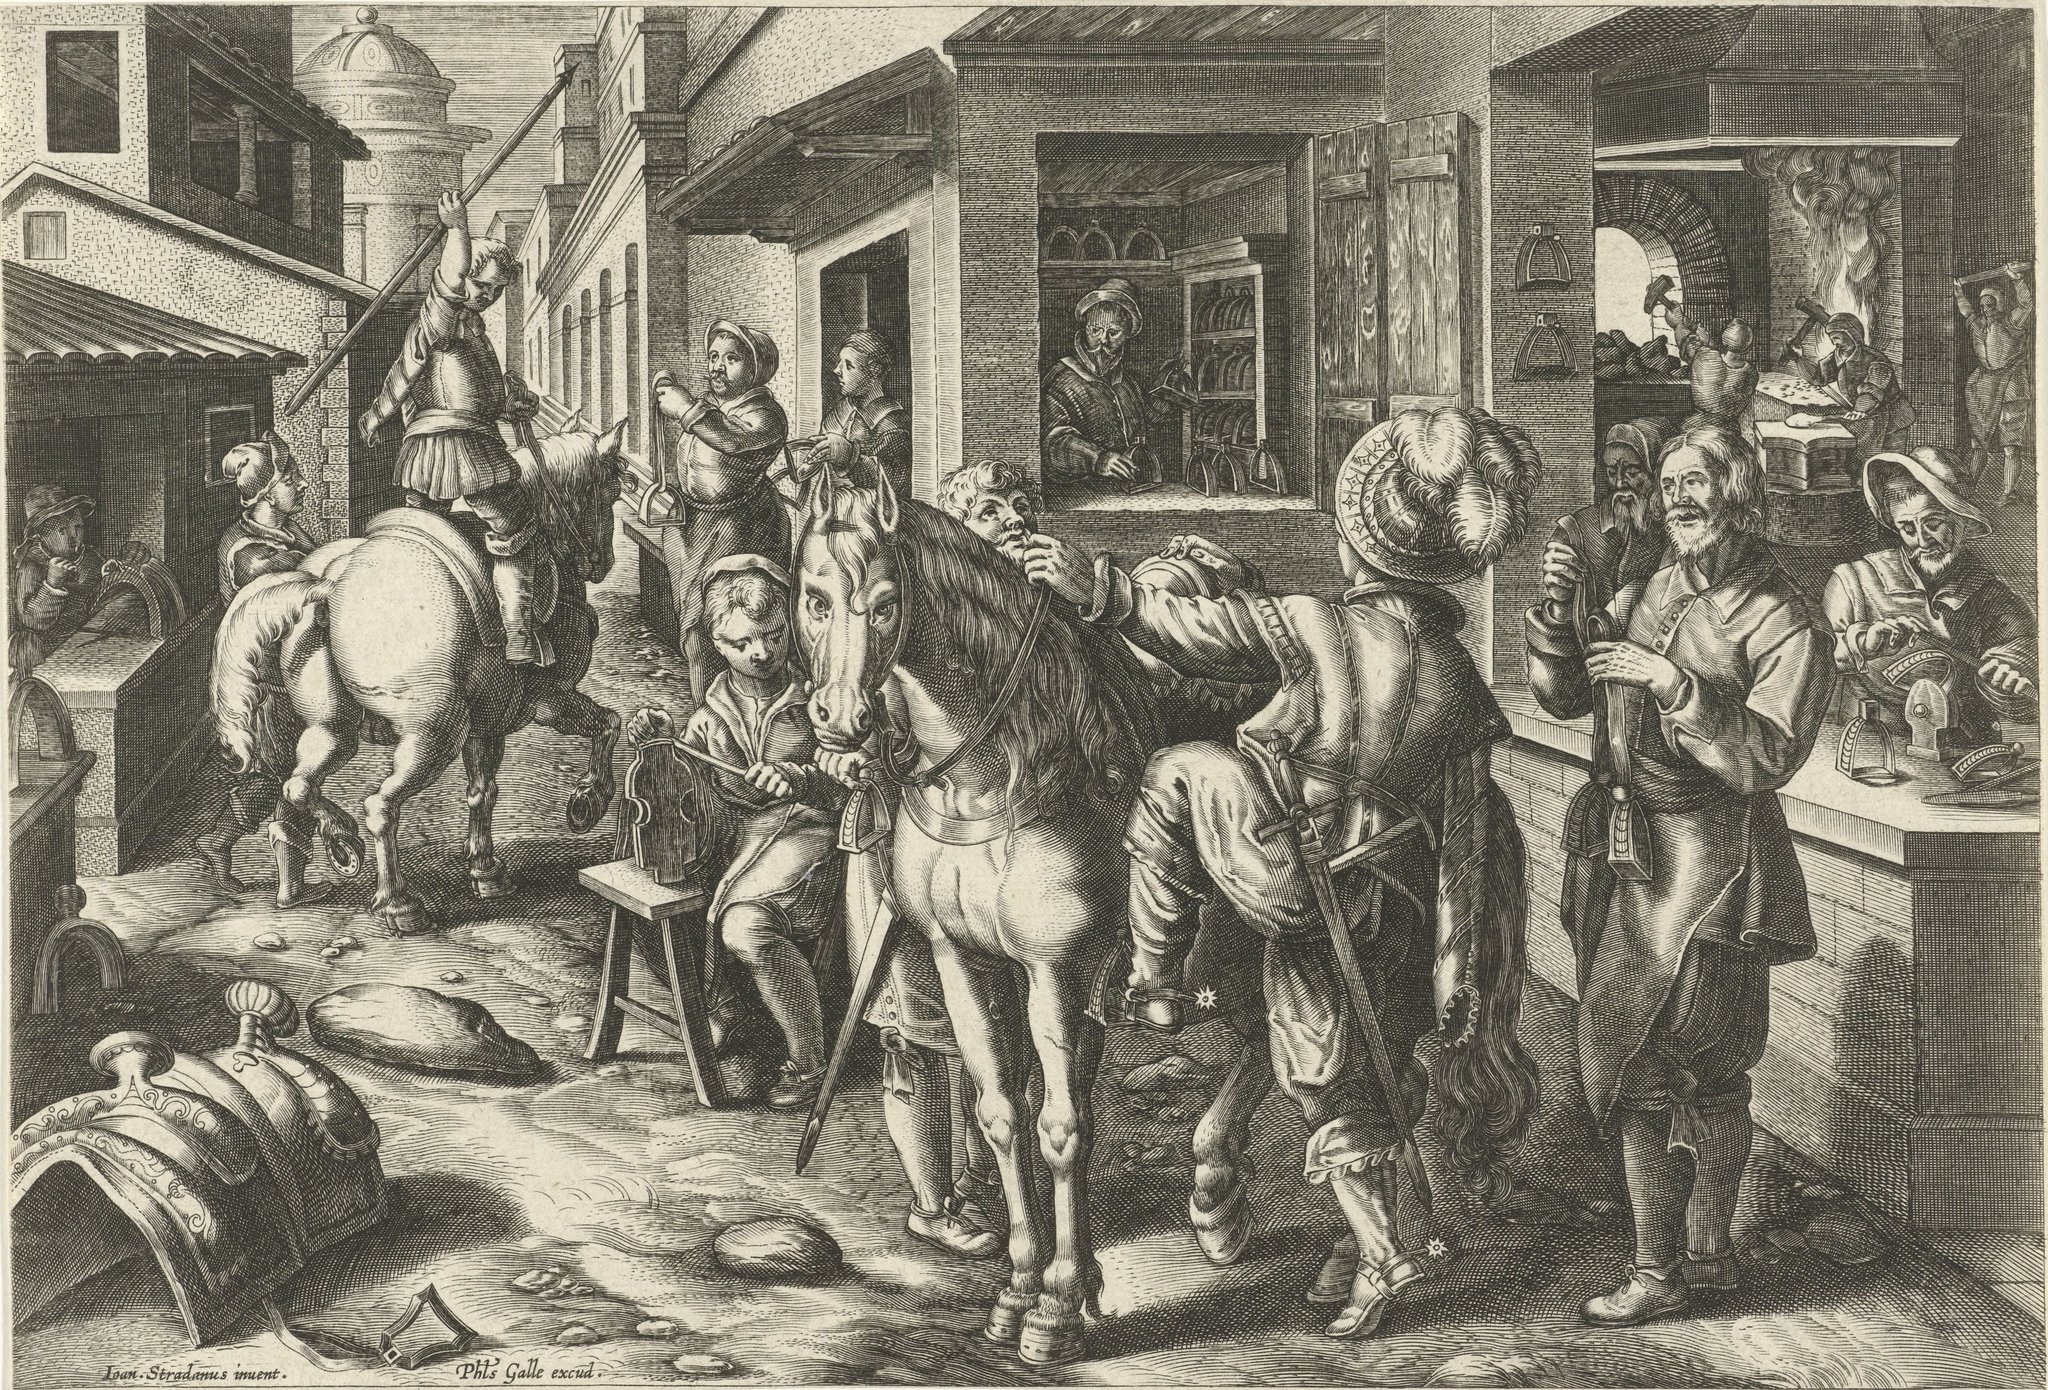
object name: print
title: Nieuwe uitvindingen en ontdekkingen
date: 1594-1598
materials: paper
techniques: engraving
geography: antwerp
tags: shop, store, riding a horse, ass, or mule; rider, horseman, saddle and bridle (saddlery), stirrup, invention, discovery ~ science and technology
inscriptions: collector's mark: Lugt 2228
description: Een straat waar paardentuig wordt gemaakt en verkocht. Op de voorgrond bestijgt een edelman zijn paard met behulp van de nieuwe stijgbeugels die hij in een winkel heeft gekocht. De prent maakt deel uit van een negentiendelige serie over nieuwe uitvindingen en ontdekkingen